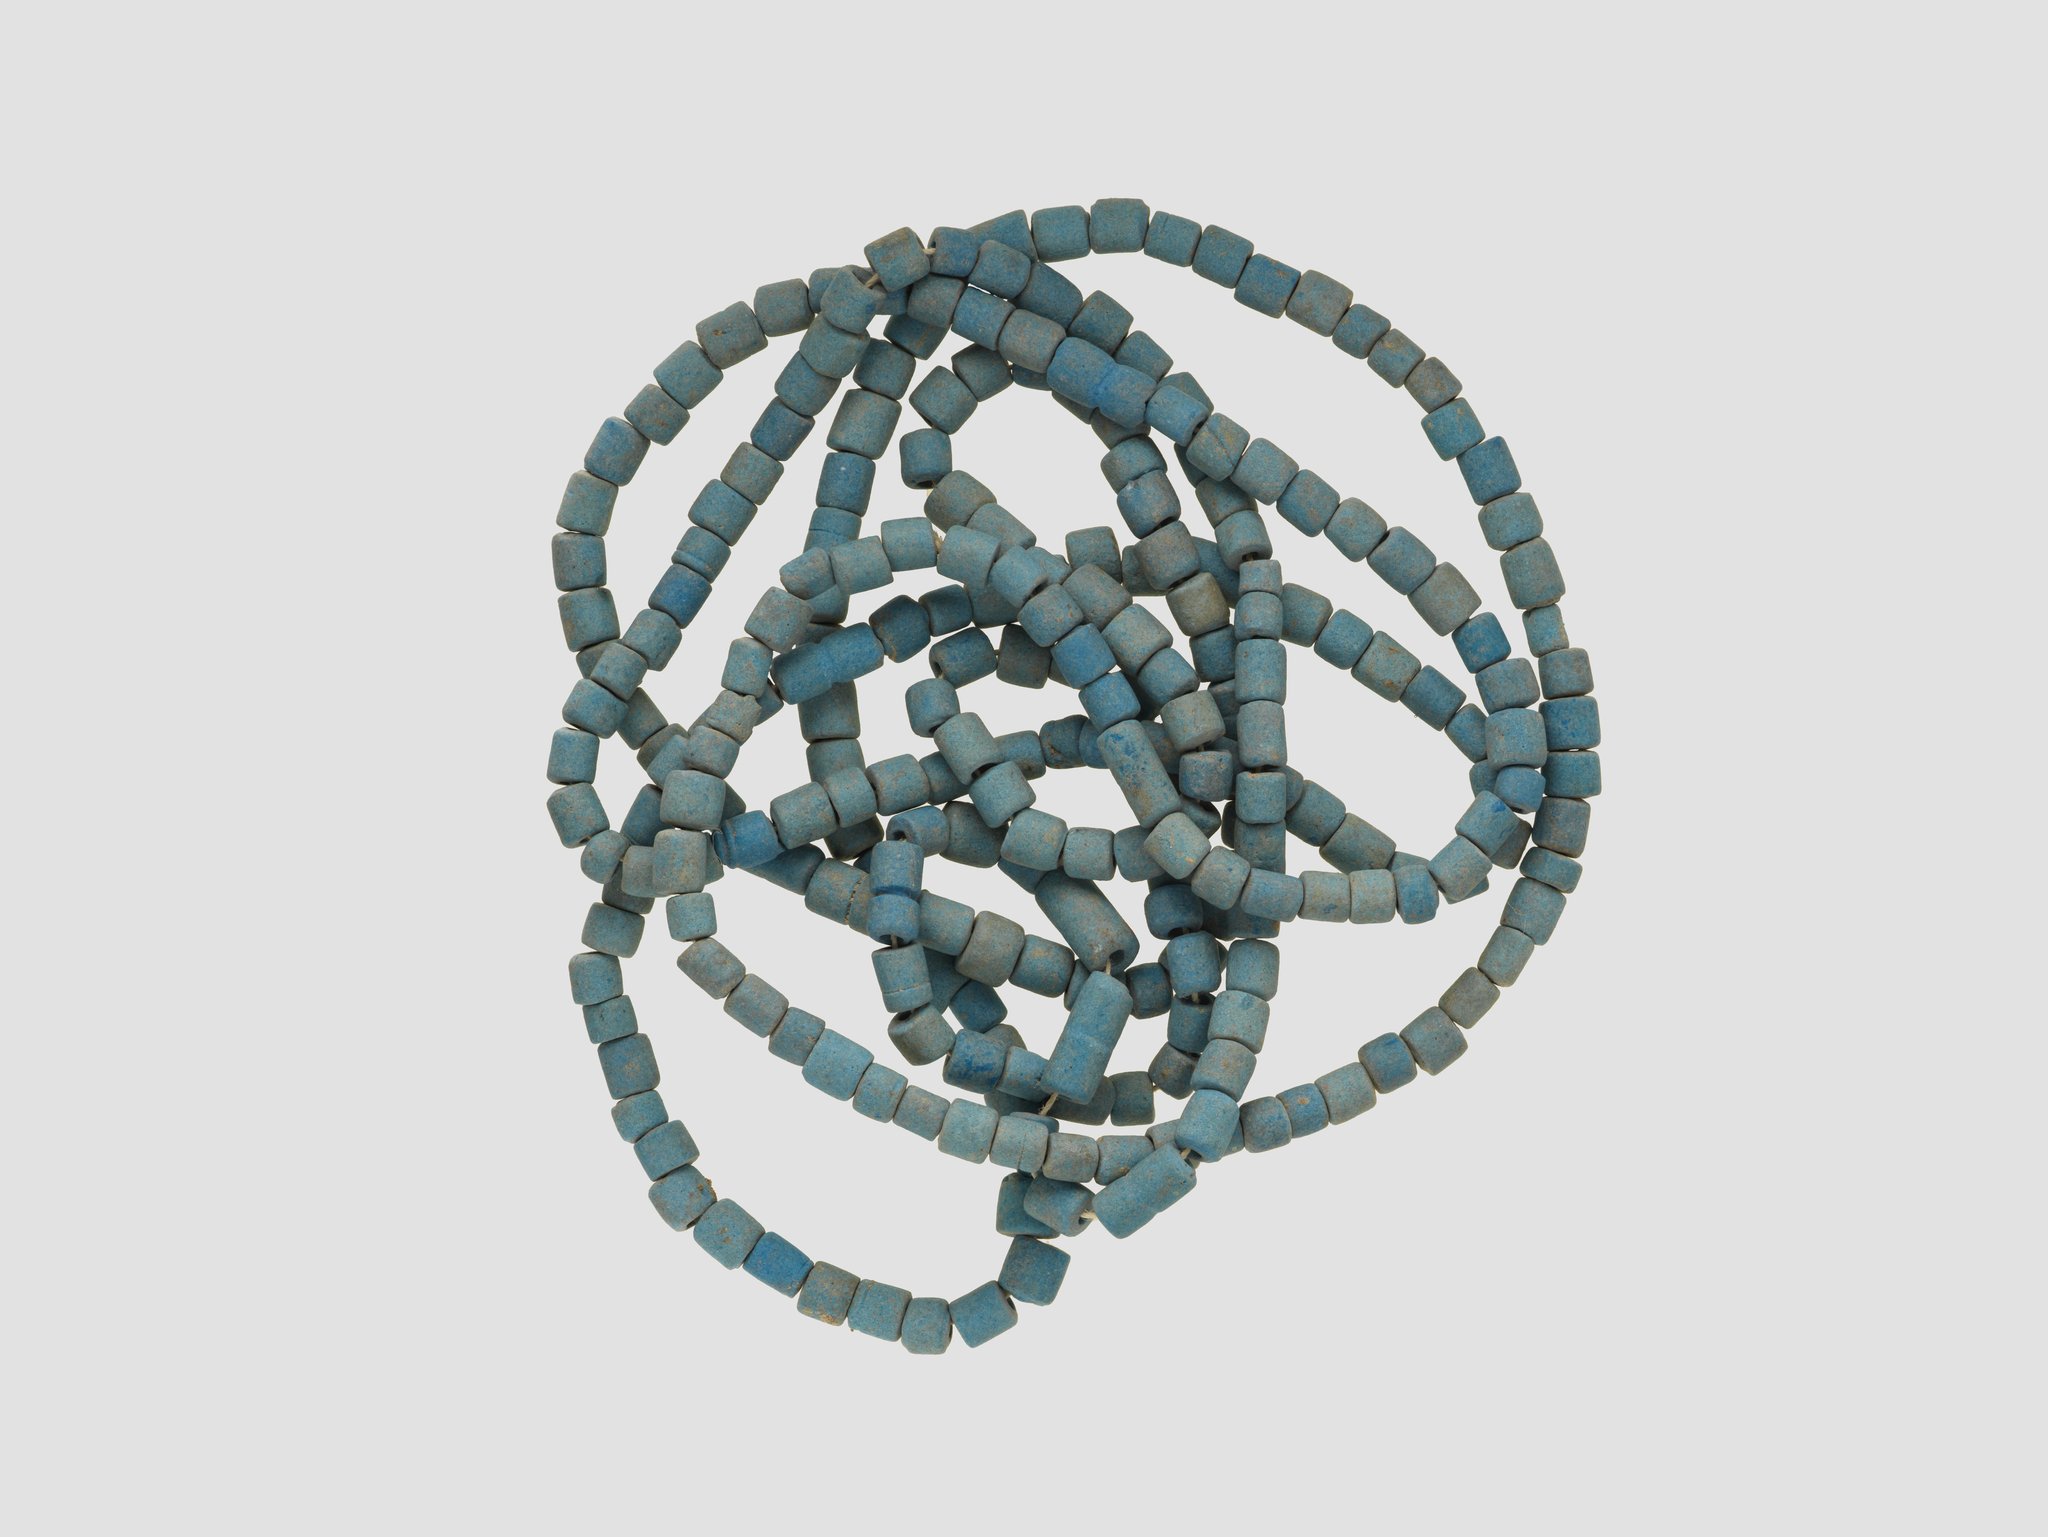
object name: necklace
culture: iranian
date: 900-801 BCE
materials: faience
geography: iran